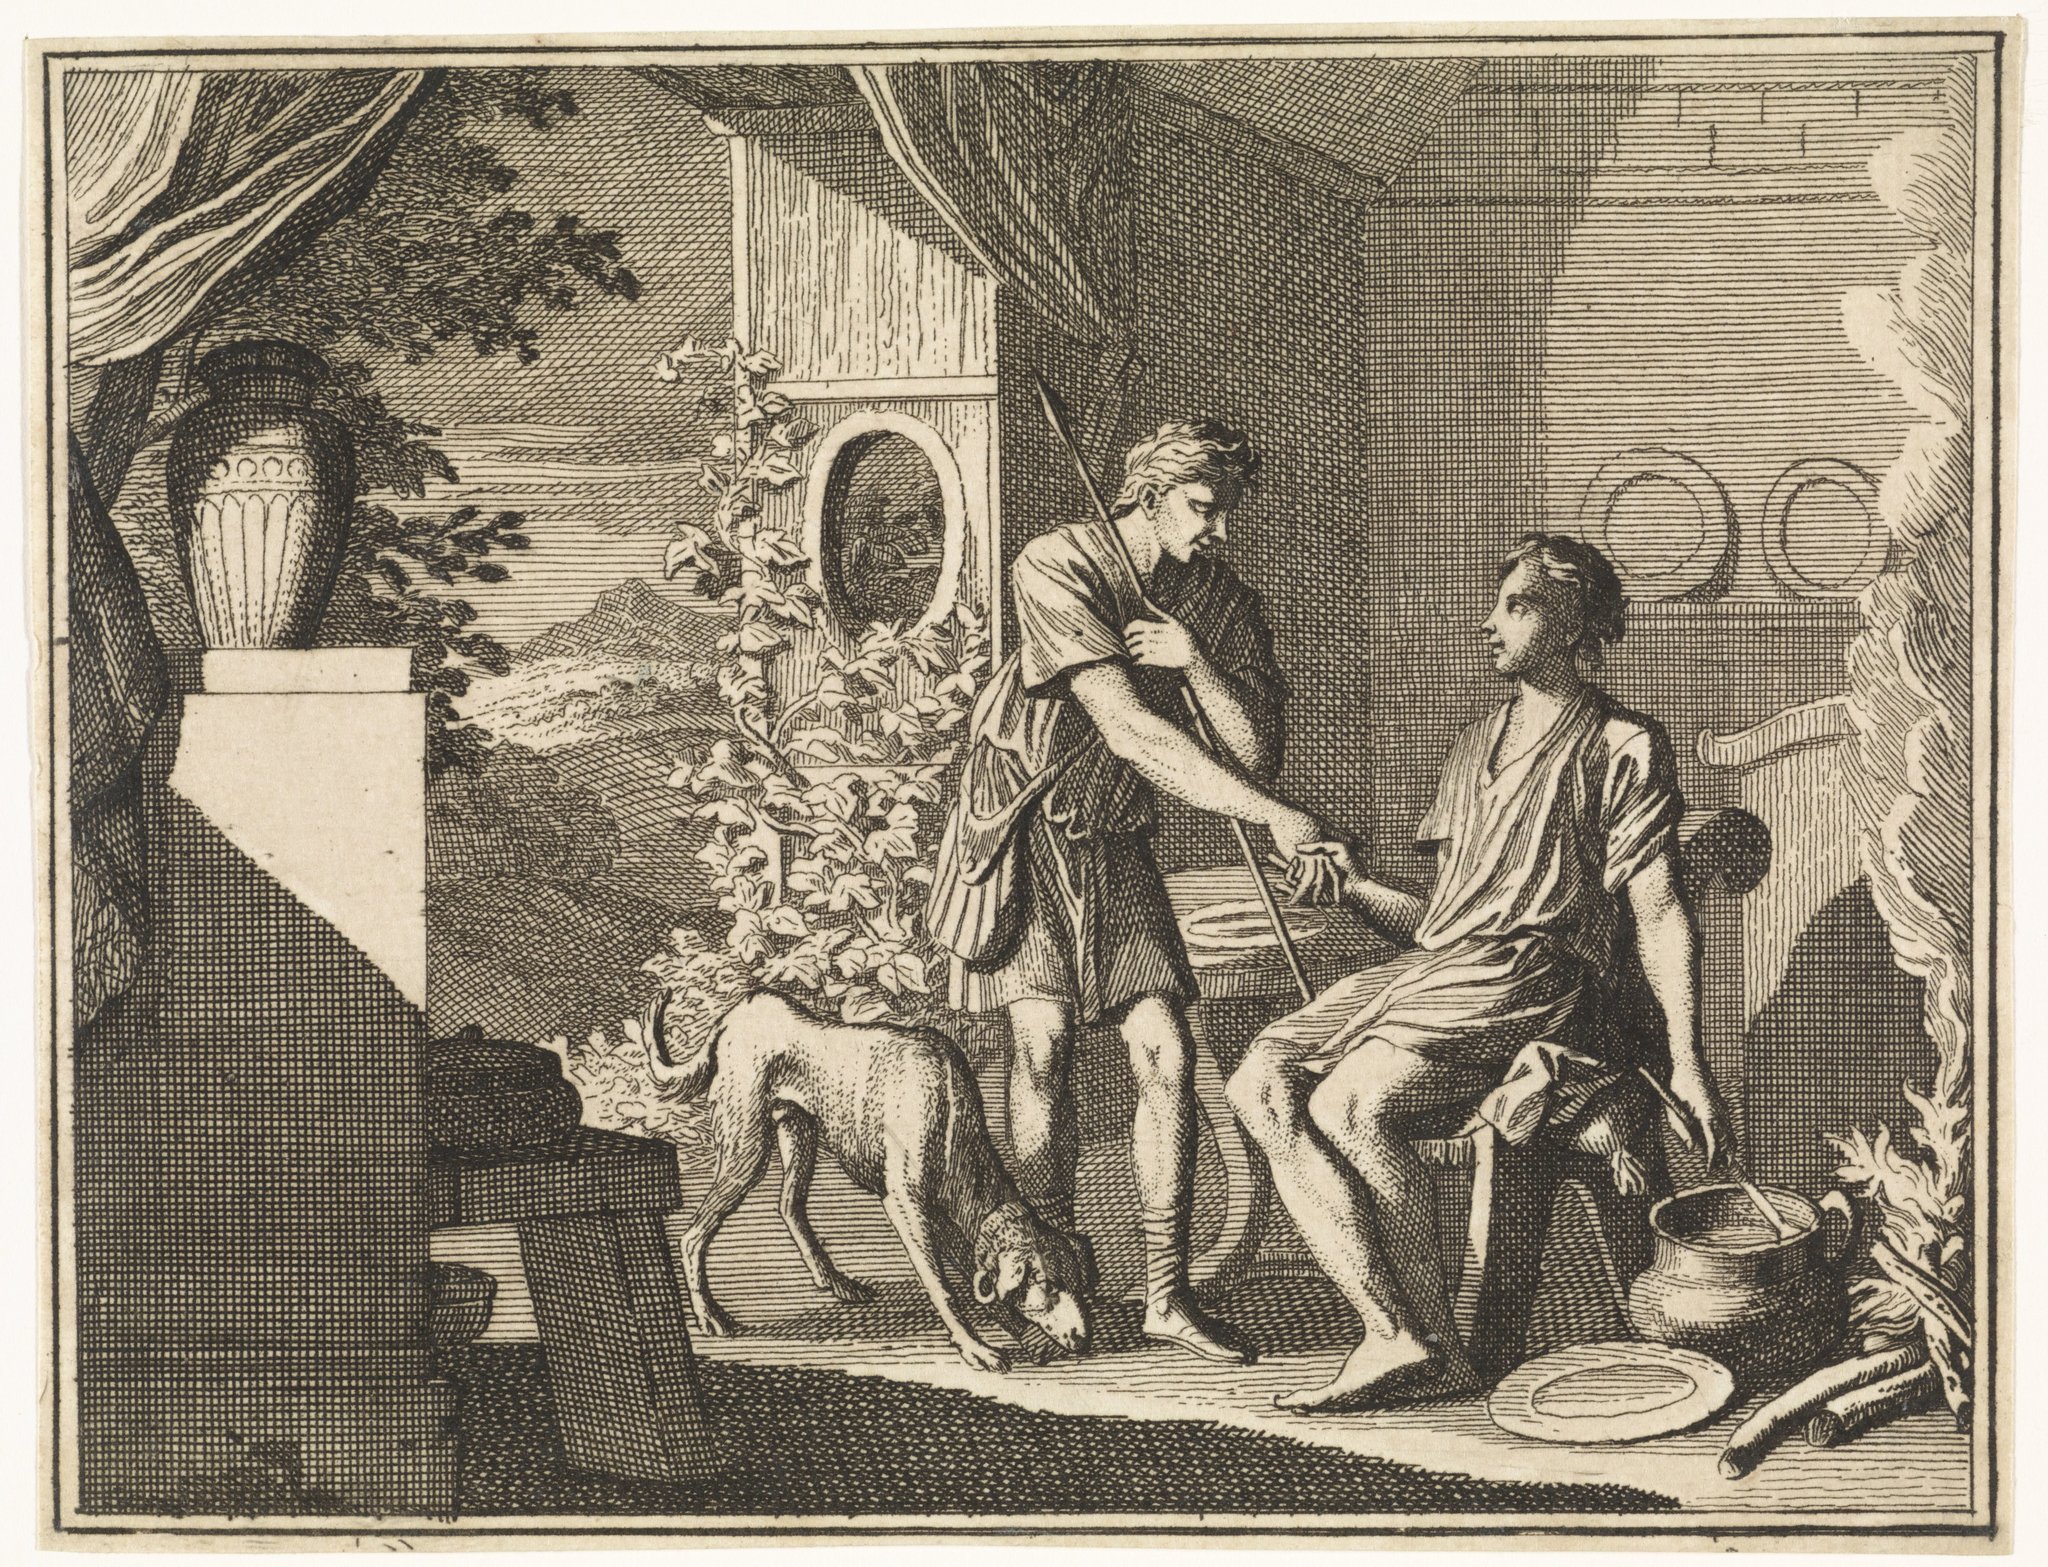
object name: print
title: Esau verkoopt zijn eerstgeboorterecht aan Jakob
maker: caspar luyken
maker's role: draughtsman, print maker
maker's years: 1672-1708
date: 1712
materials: paper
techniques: etching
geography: amsterdam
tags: esau, returning hungry from the hunt, sells his first birthright to jacob for a pottage of lentils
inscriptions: number: ‘28’, collector's mark: Lugt 2228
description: Illustratie uit: Luyken, Jan. De schriftuurlyke geschiedenissen en gelykenissen van het Oude en Nieuwe Verbond, 2 delen. Amsterdam: Wed. Pieter Arentsz II en Cornelis van der Sys, 1712, dl. I.